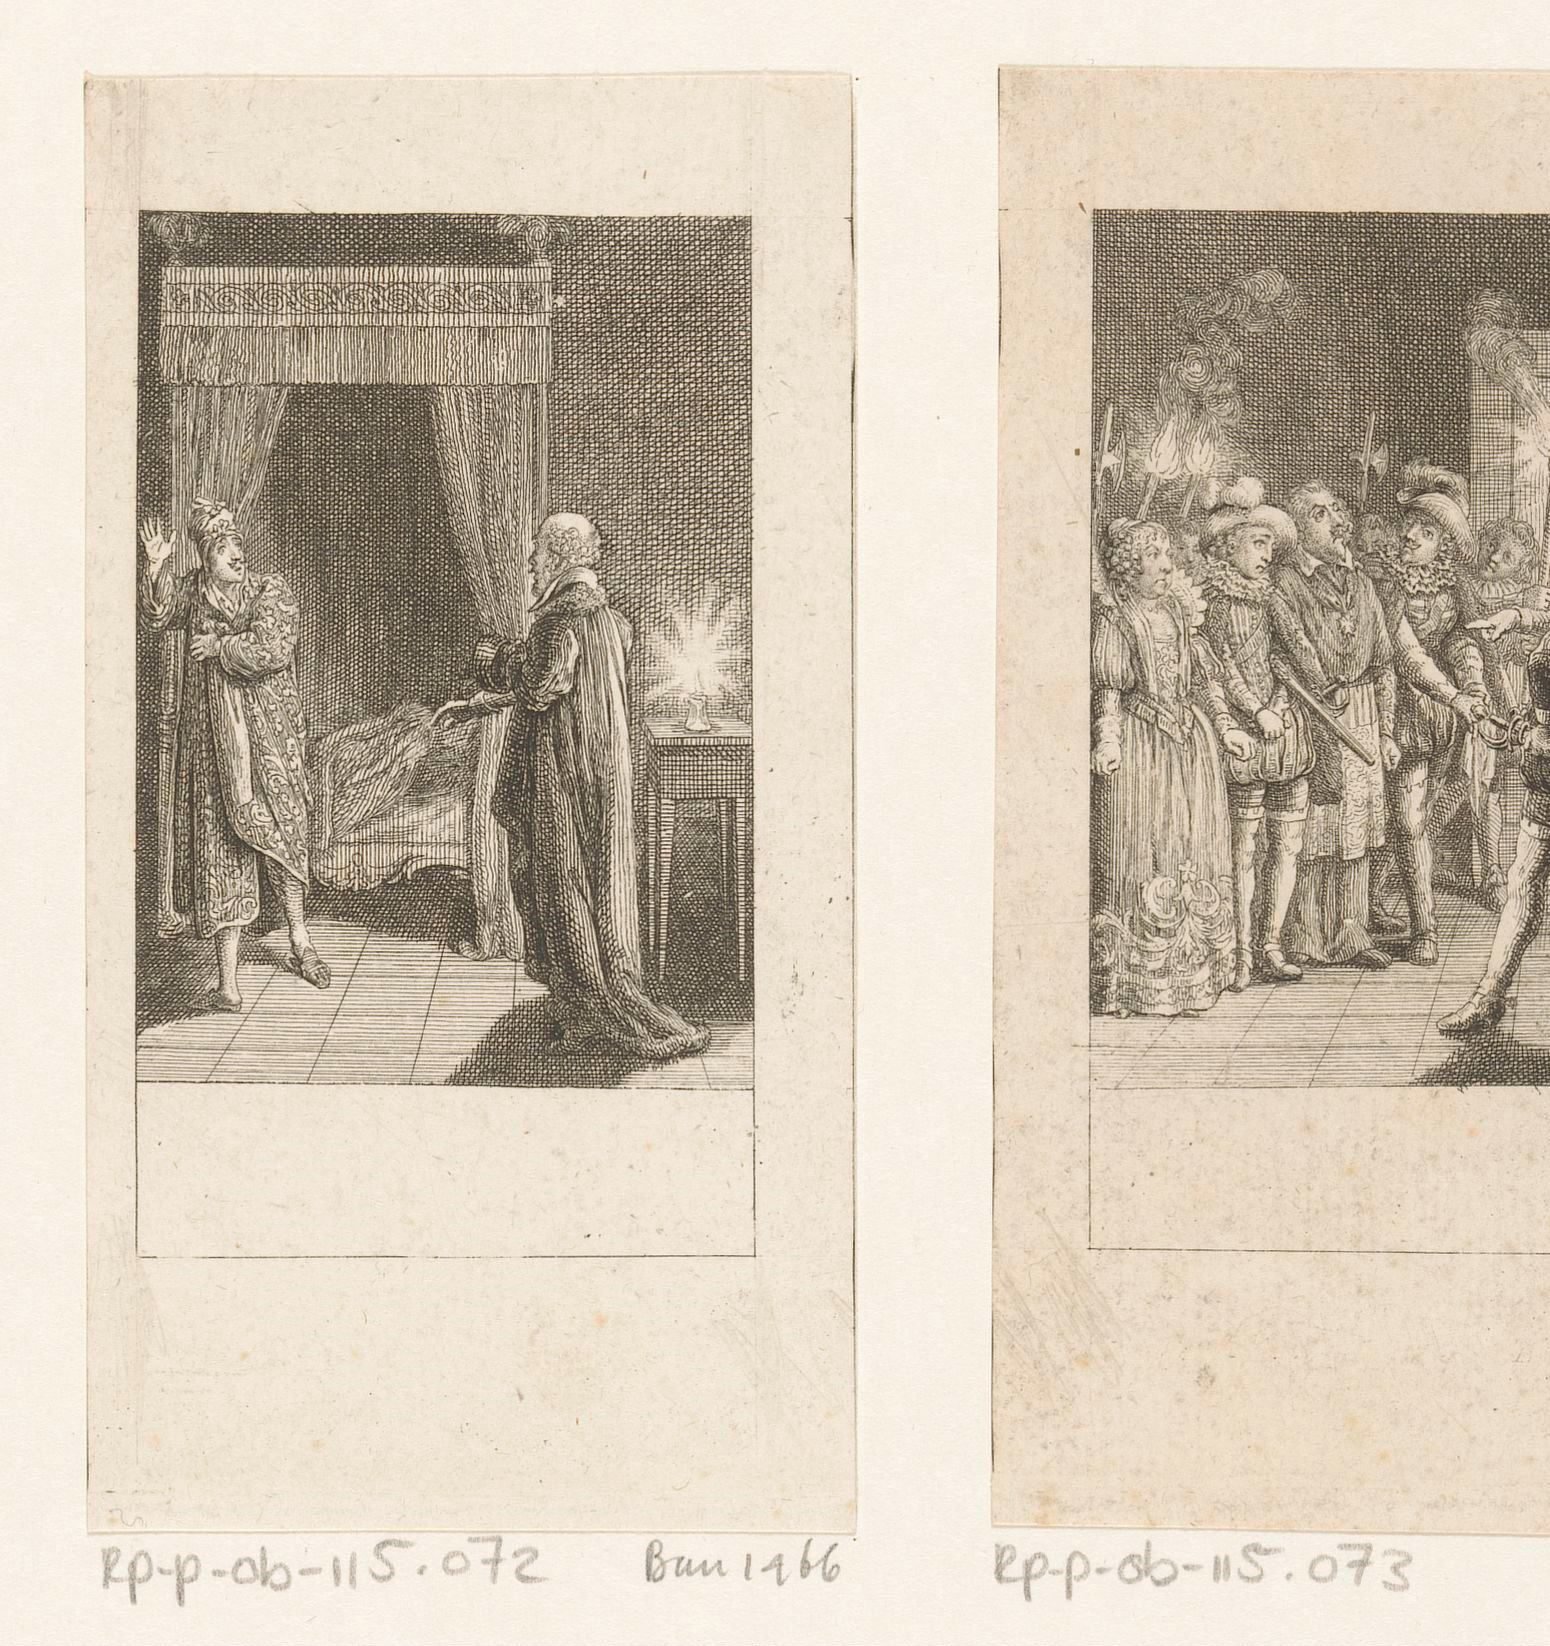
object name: print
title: Michel l'Hopital vertelt Hendrik van Navarra over de moord op Coligny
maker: daniel nikolaus chodowiecki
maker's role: draughtsman, print maker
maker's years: 1726-1801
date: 1790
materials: paper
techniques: etching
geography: berlin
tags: paris, hendrik iv (koning van frankrijk en navarra), messenger, bedroom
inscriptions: collector's mark: Lugt 2228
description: Vervaardigd voor 'Charles IX' van Marie-Joseph Chénier. Latere staat gebruikt voor: Goettinger Taschen Calender für 1791. bey Joh. Chr. Dietrich. Göttingen: Johann Christoph Dietrich, [1790].